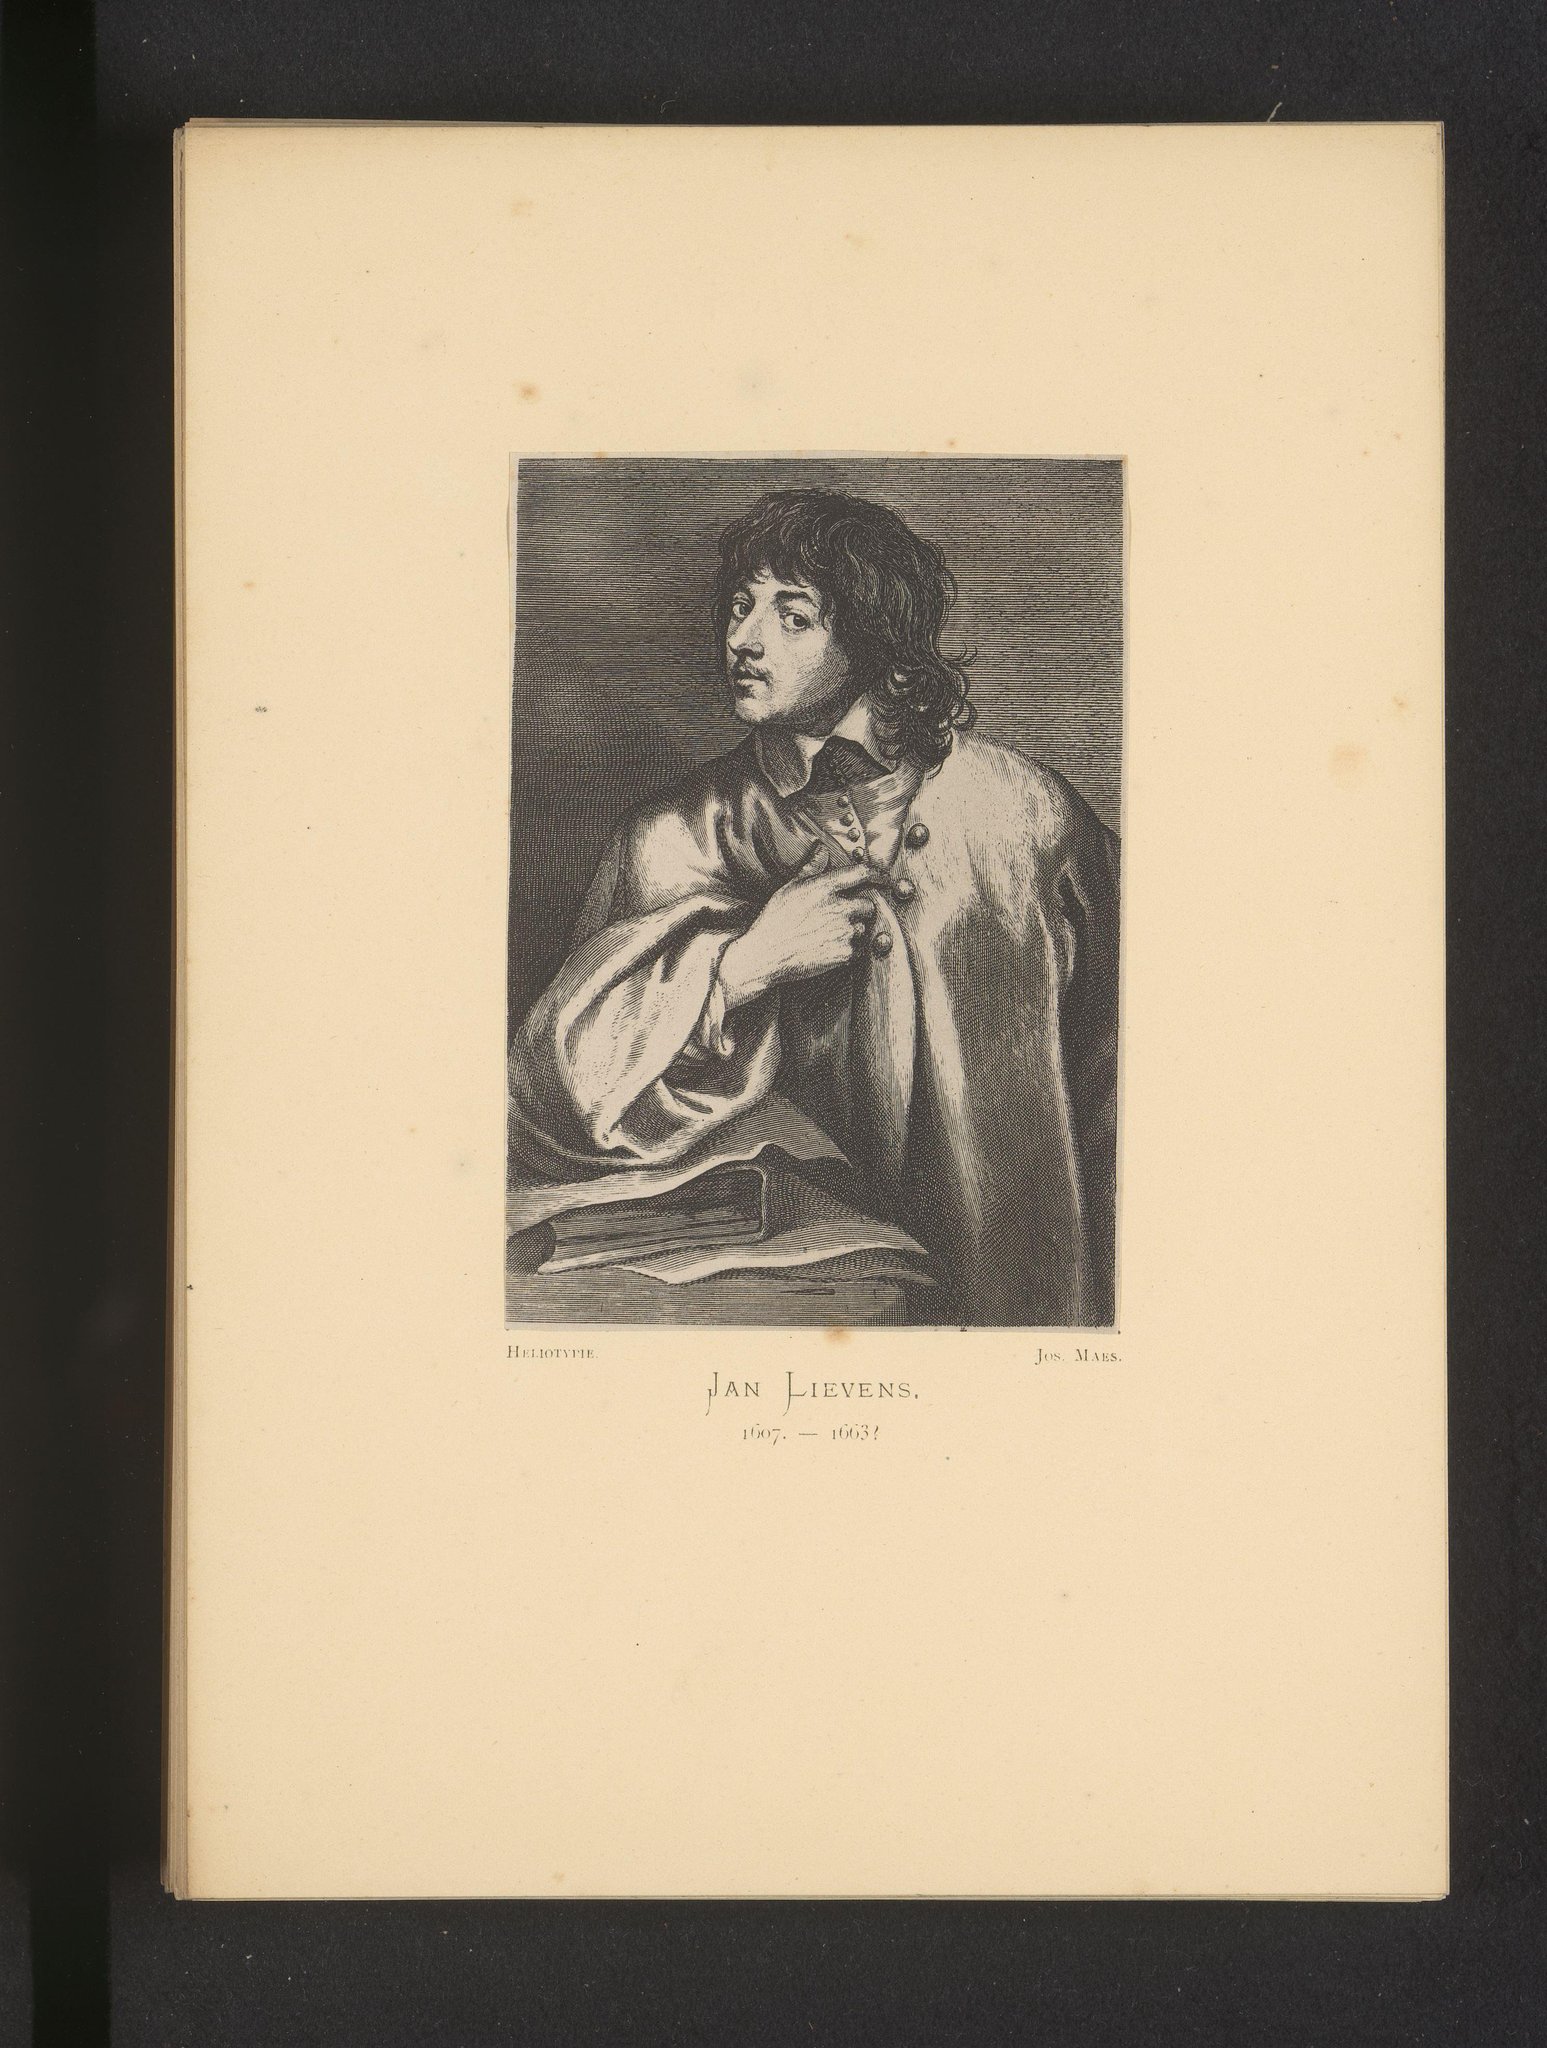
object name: reproduction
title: Reproductie van een gravure van een portret van Jan Lievens door Lucas Vorsterman (I)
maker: joseph maes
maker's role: fotograaf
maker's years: 1838-1908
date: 1872-1877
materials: cardboard, paper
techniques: photograph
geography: antwerp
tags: leiden, painter, print maker, draughtsman, jan lievens, historical persons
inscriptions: inscription: ‘1607. - 1663?’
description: Deze prent maakt deel uit van een omslag met 150 prenten en een katern met een lijst van afbeeldingen.